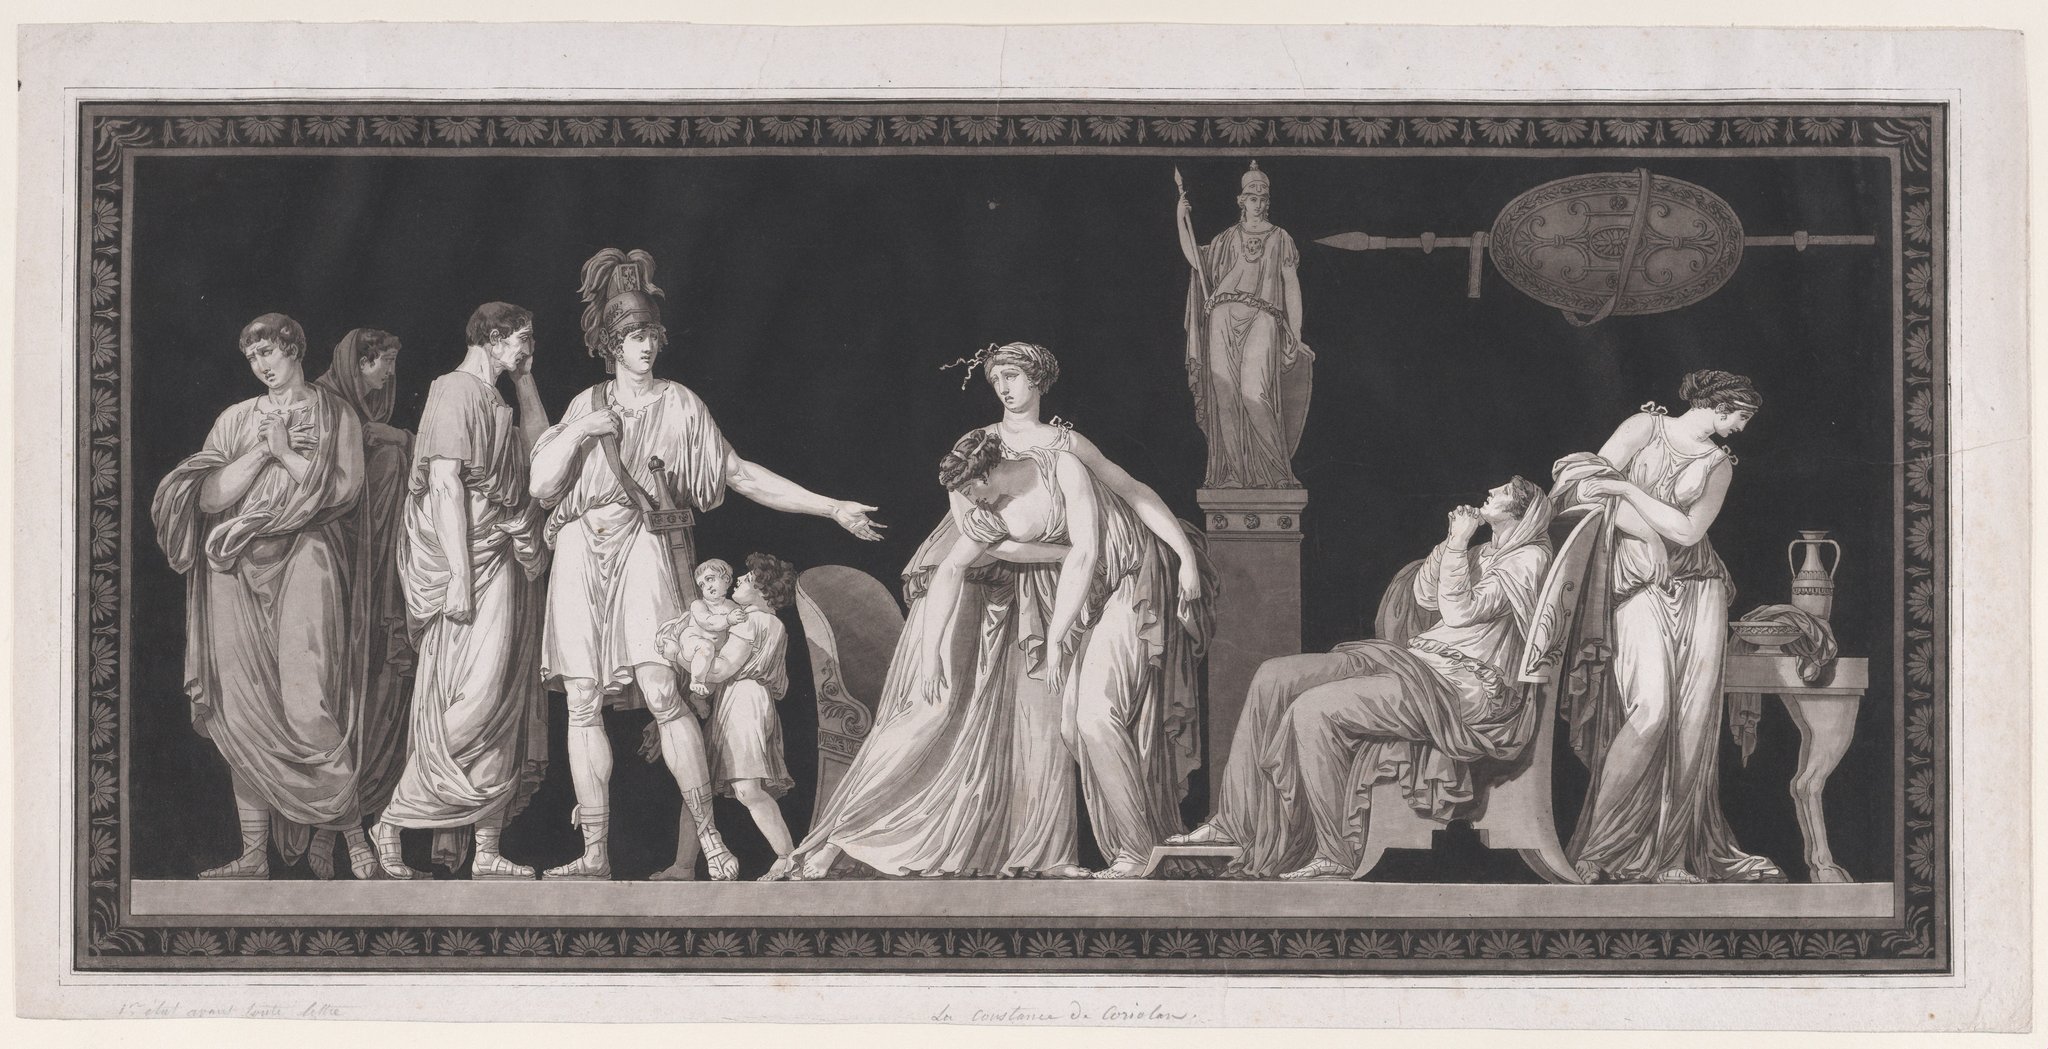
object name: print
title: The Constancy of Coriolanus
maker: jean françois janinet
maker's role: artist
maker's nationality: french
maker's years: 1752-1814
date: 1778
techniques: etching, roulette